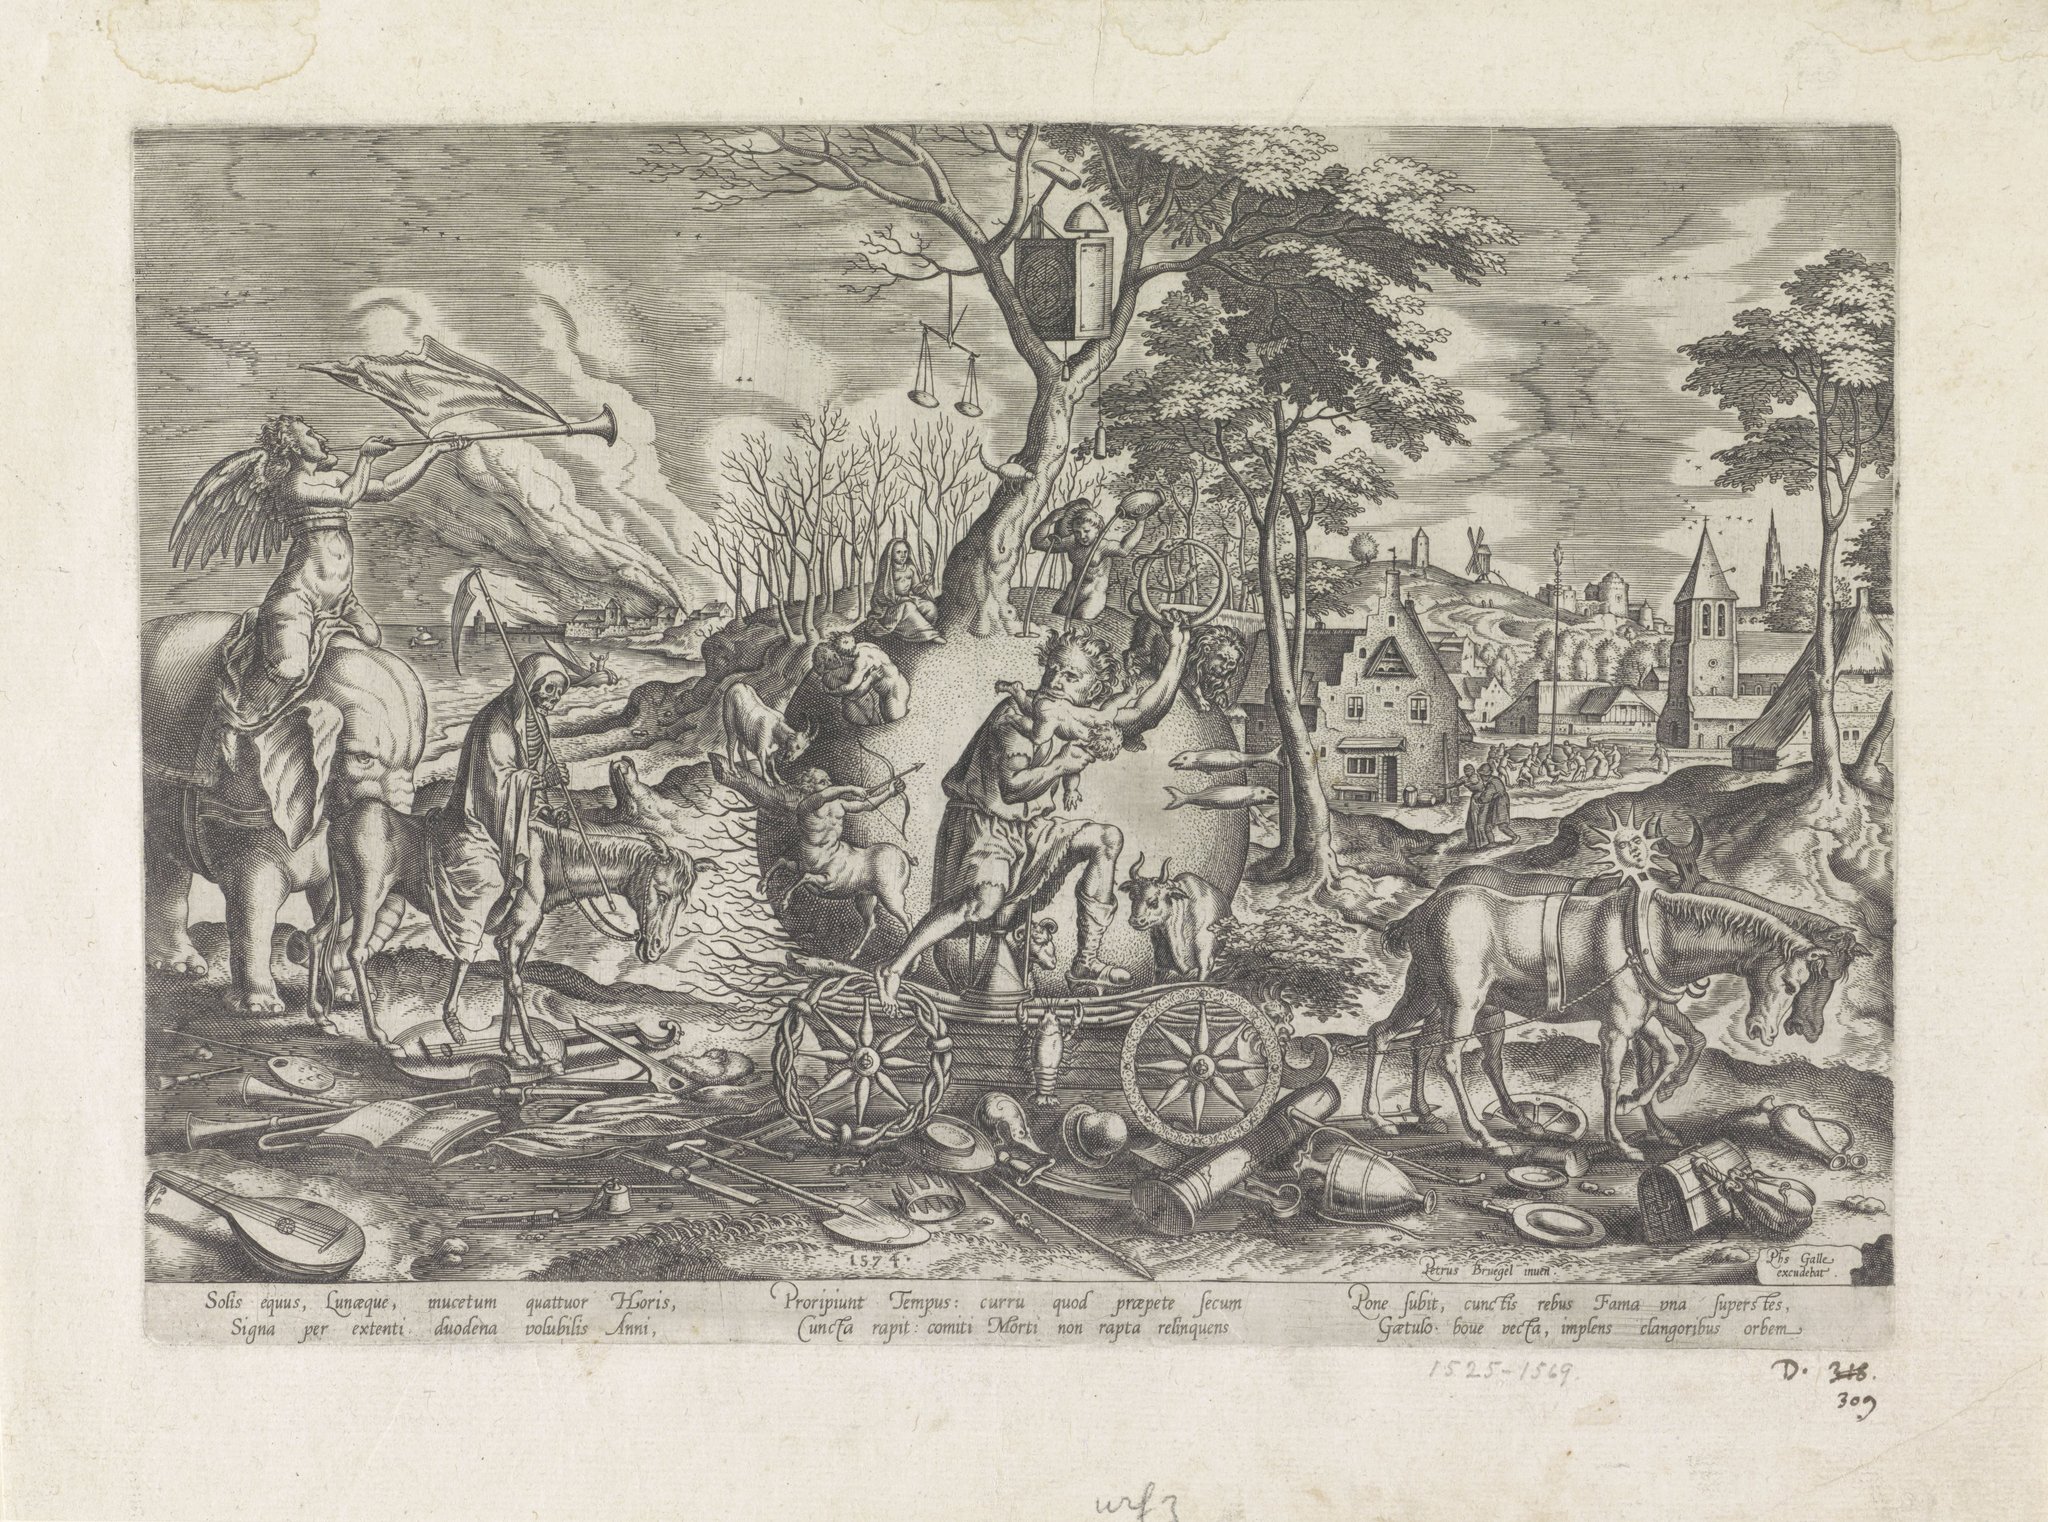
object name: print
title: Triomf van de Tijd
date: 1574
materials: paper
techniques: engraving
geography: antwerp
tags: death as skeleton, saturn devouring his children, zodiac; the twelve zodiacal signs together, triumph of saturn; 'carro di saturno' (ripa)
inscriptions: collector's mark: Lugt 2228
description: Saturnus als personificatie van de Tijd staat op zijn triomfwagen die voortgetrokken wordt door paarden. Hij verslindt zijn kinderen en zit op een zandloper staande voor een globe met de tekens van de dierenriem. Achter hem rijdt de personificatie van de Dood te paard. Daarachter Overwinning rijdend op een olifant. Op de grond liggen muziekinstrumenten, boek, hoofddeksels, geldkist en geldbeurs. In de boom hangt een klok. Links op de achtergrond een brandende stad. Onder de voorstelling drie tweeregelige verzen in het Latijn.